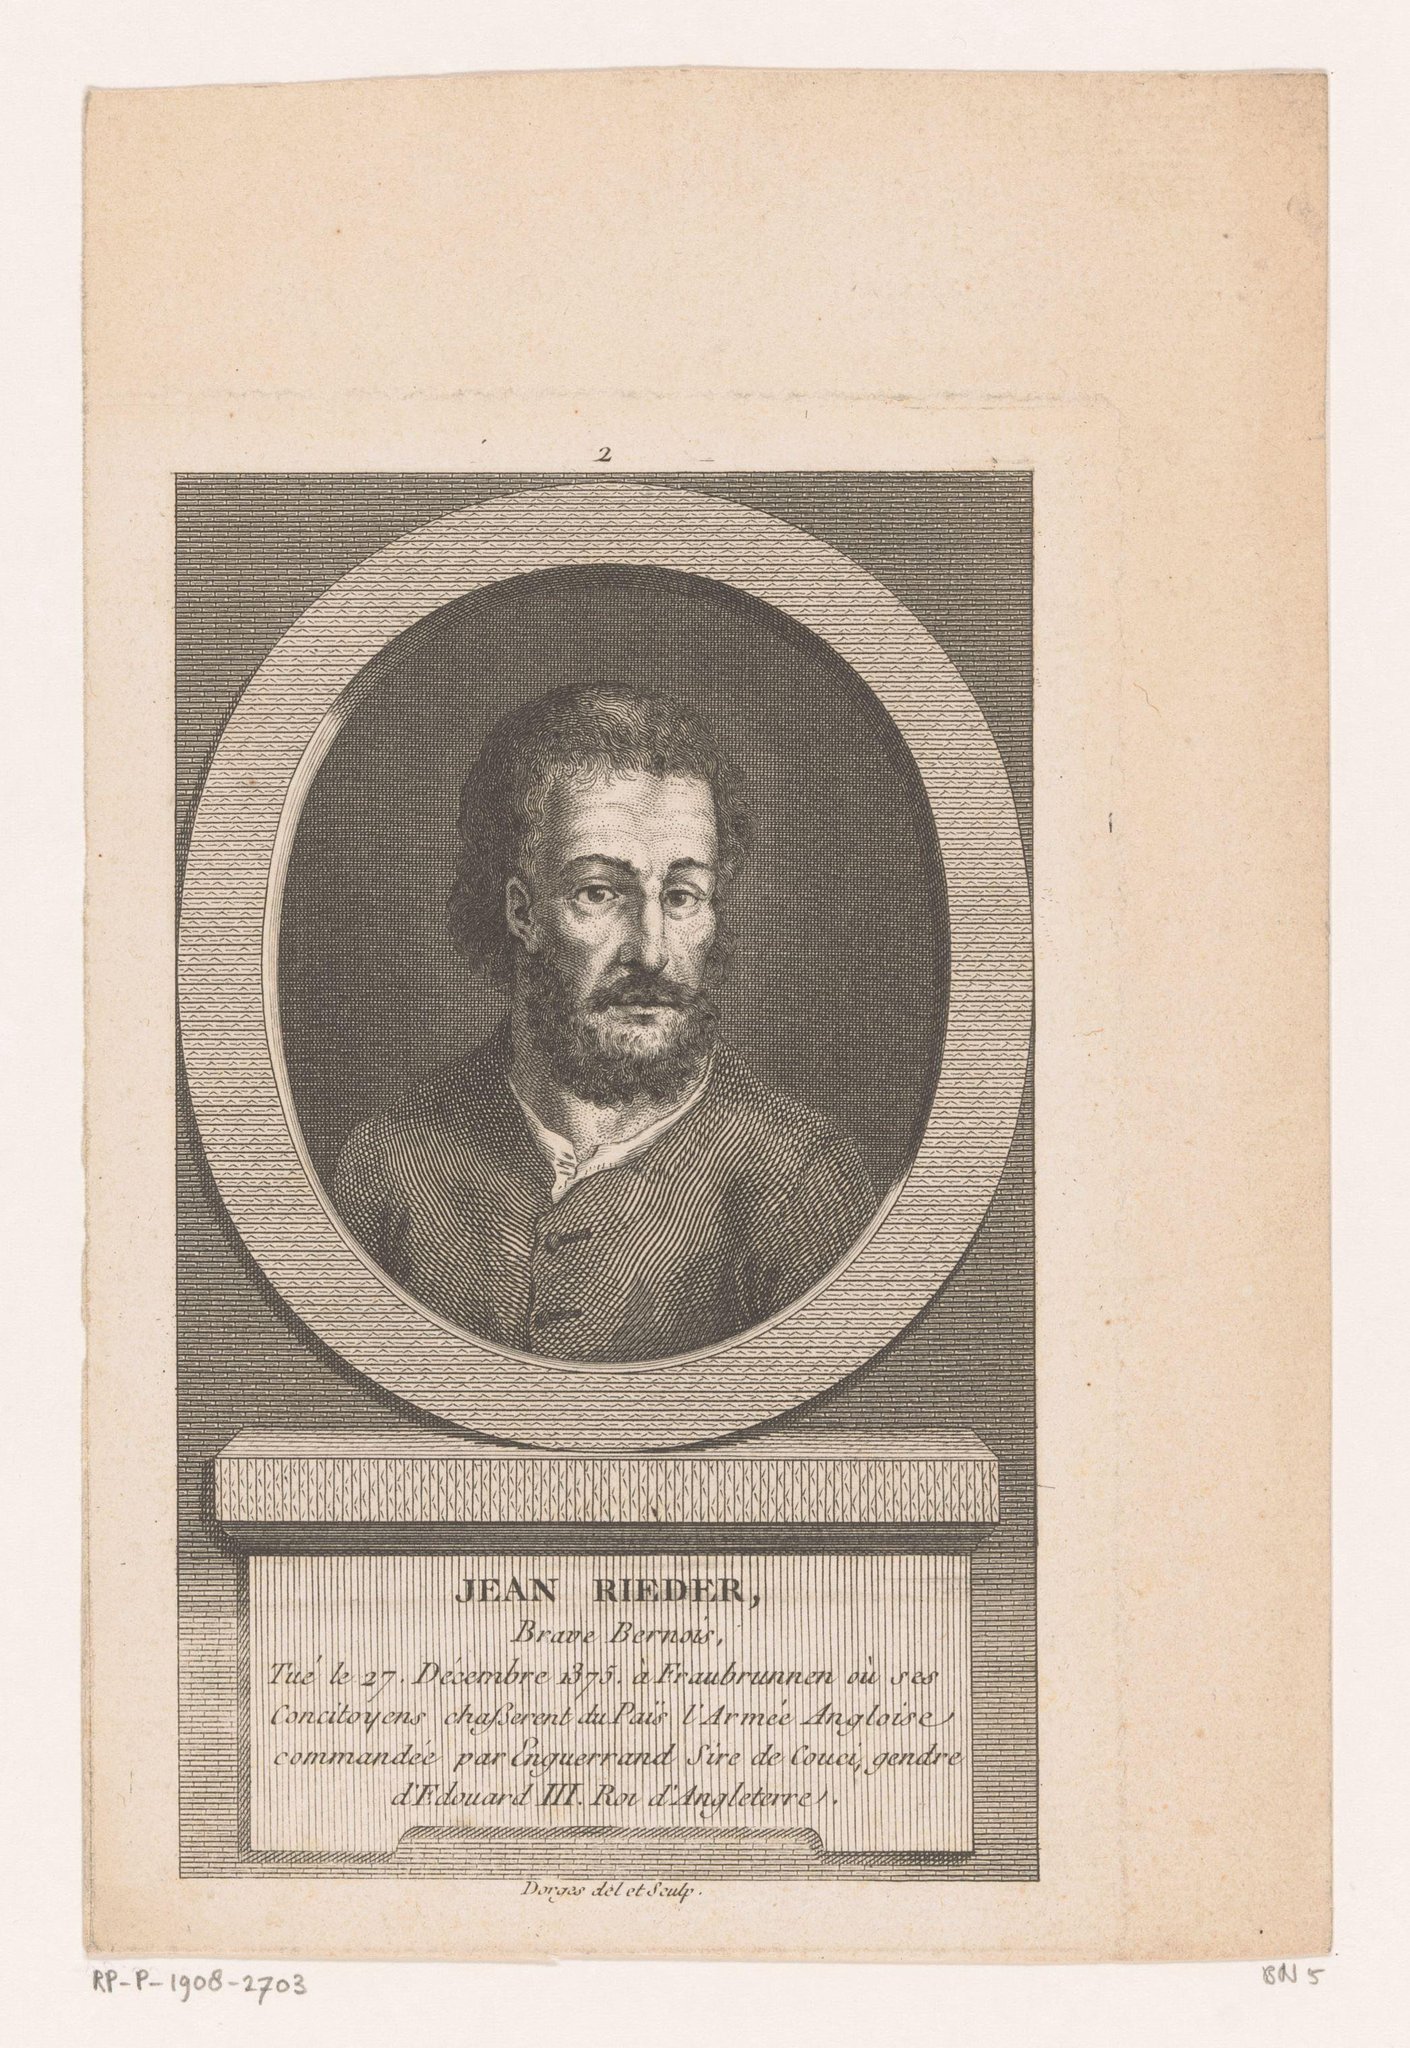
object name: print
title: Portret van Jean Rieder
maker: dorgez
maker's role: print maker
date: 1784-1786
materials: paper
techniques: engraving, etching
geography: paris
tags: historical persons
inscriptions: collector's mark: Lugt 2228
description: Prent uit: Tableaux de la Suisse. Parijs: 1784-1786, dl. 3, p. 302.